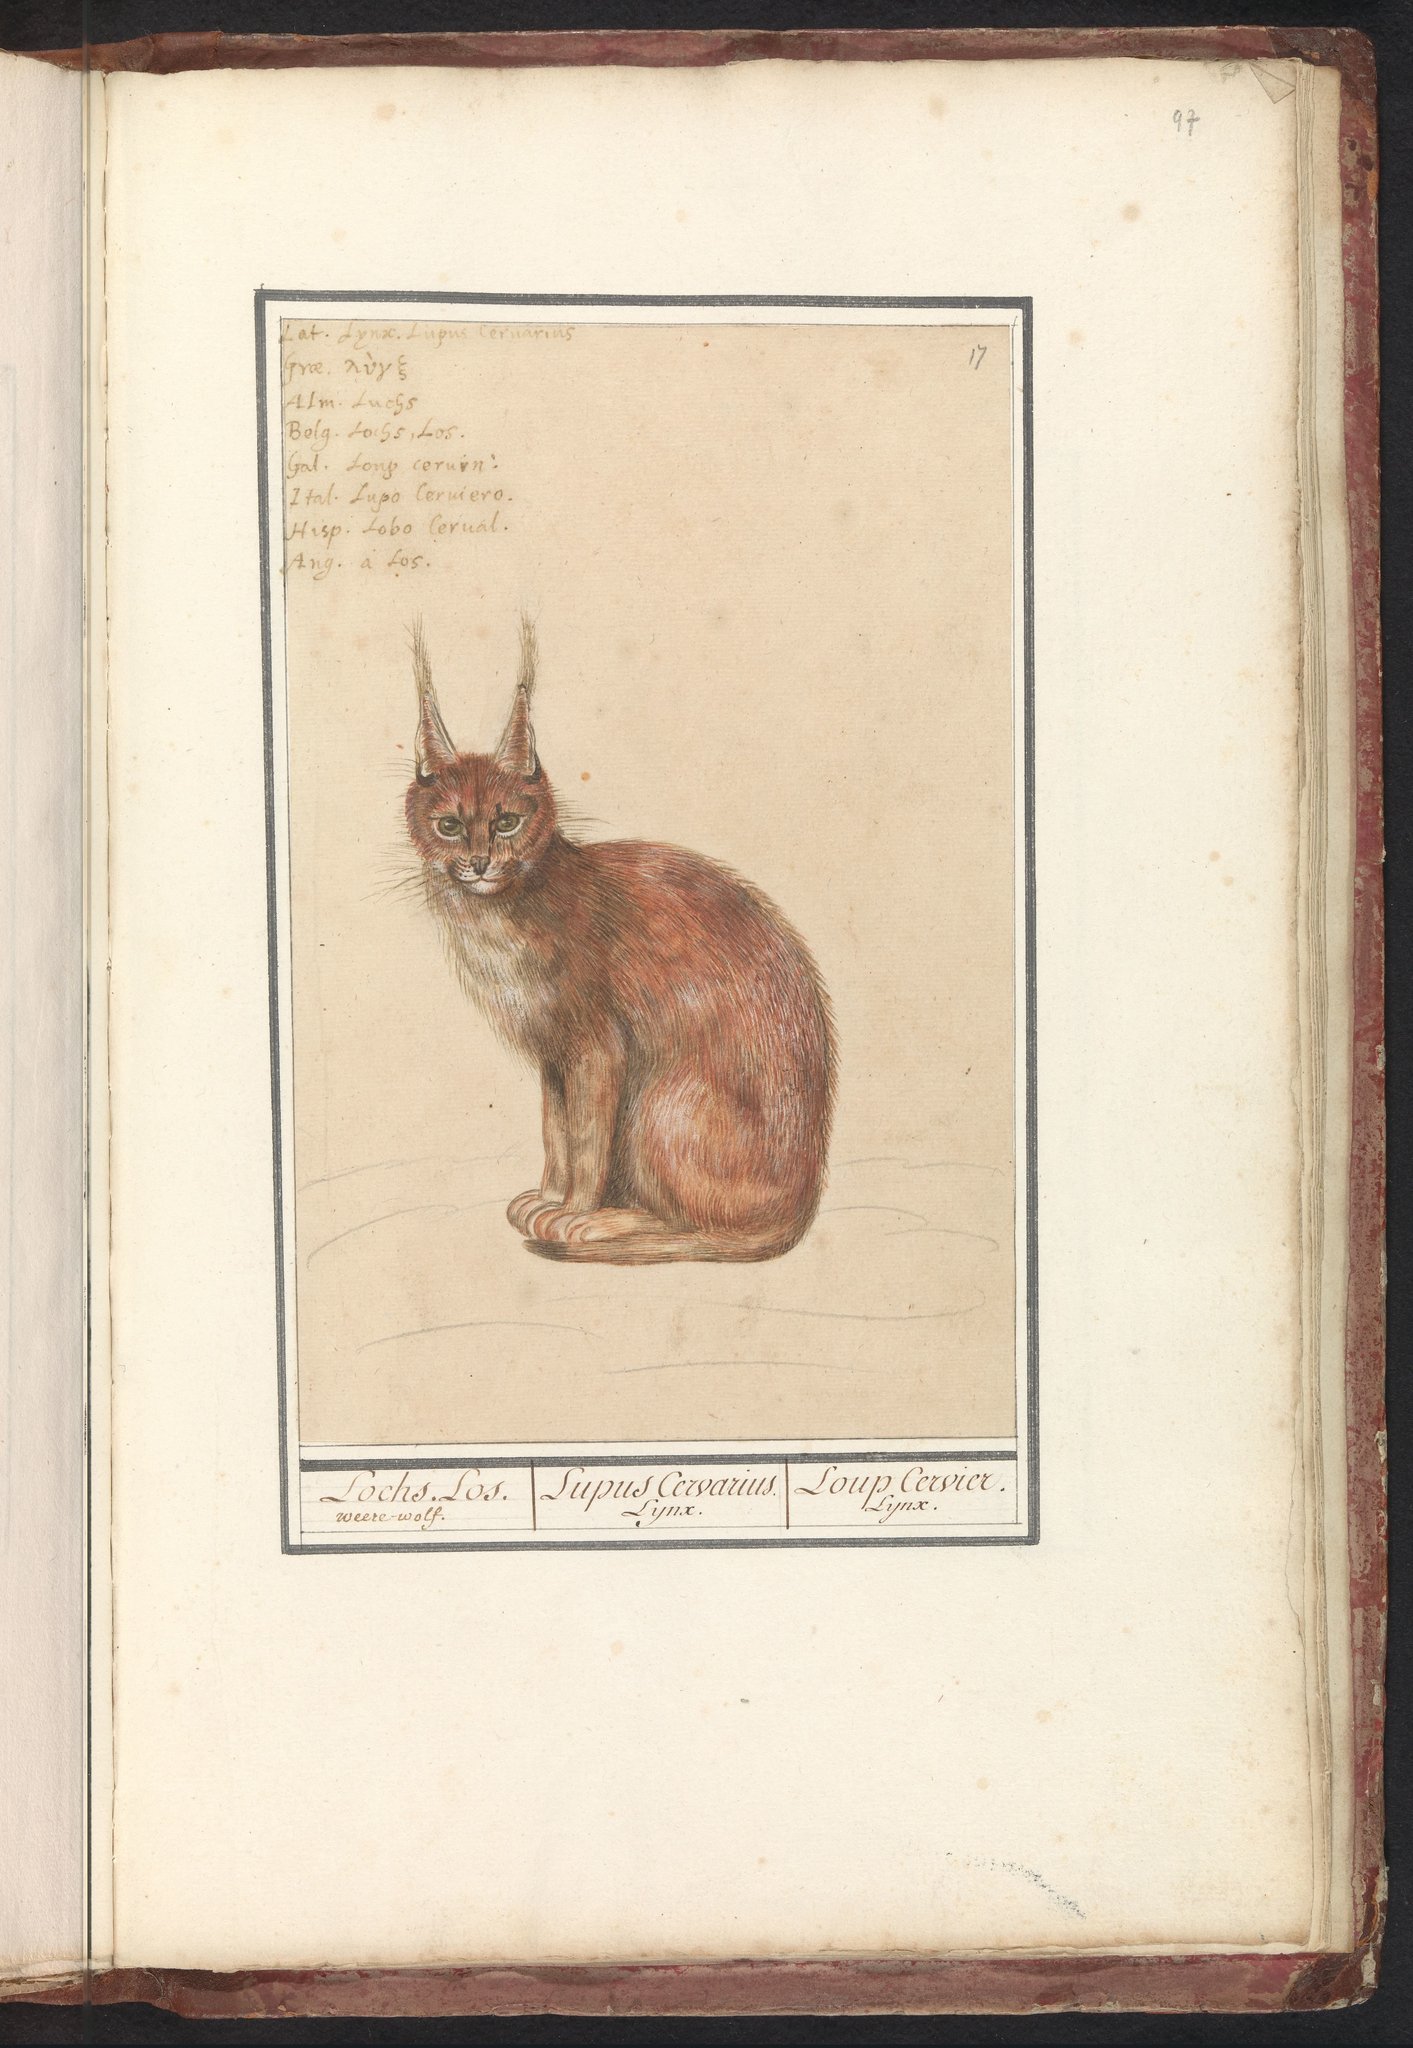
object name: drawing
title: Lochs. Los. weere-wolf. / Lupus Cervarius. Lynx. / Loup Cervier. Lynx.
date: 1596-1610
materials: paint, ink, paper, pencil, watercolor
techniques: brush, pen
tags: werewolf, lycanthrope, beasts of prey, predatory animals: lynx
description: Lynx. Genummerd rechtsboven: 17. Linksboven de naam in acht talen. Onderdeel van het eerste album met tekeningen van viervoeters. Eerste van twaalf albums met tekeningen van dieren, vogels en planten bekend rond 1600, gemaakt in opdracht van keizer Rudolf II. Met toelichting in Nederlands, Latijn en Frans.